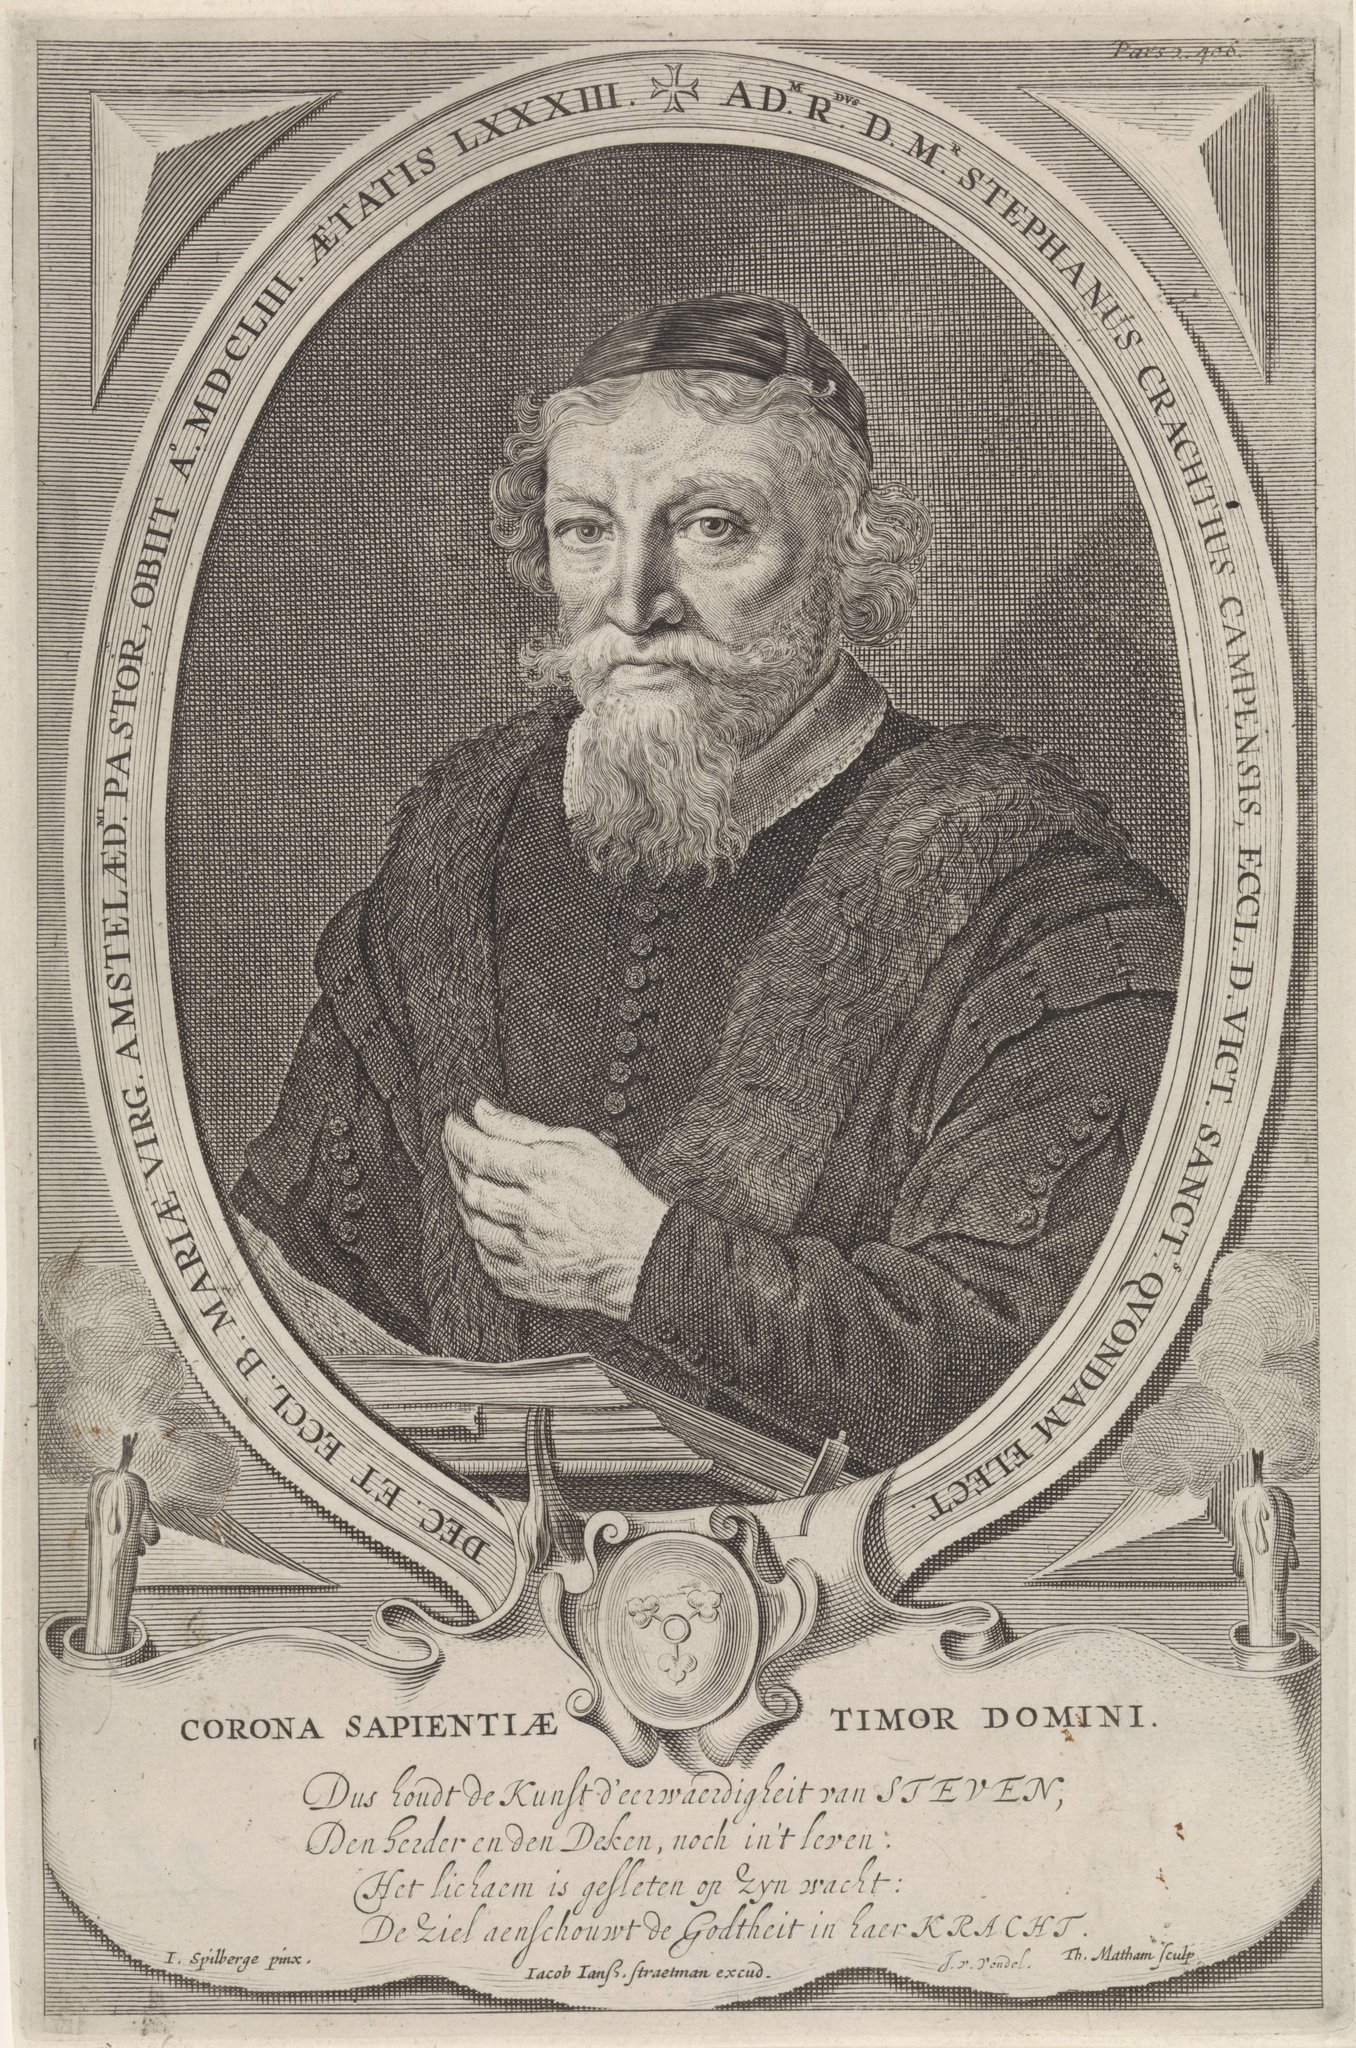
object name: book illustration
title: Portret van Stephan Crachtius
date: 1653-1676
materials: paper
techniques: engraving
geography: amsterdam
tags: theoloog, stephan crachtius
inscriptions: collector's mark: Lugt 2228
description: Prent gebruikt in: Heussen, Hugo Franciscus van. Batavia sacra, sive Res gestæ apostolicorum virorum, qui fidem Bataviæ primi intulerunt. 2 dln. Brussel: François Foppens (II), 1714.